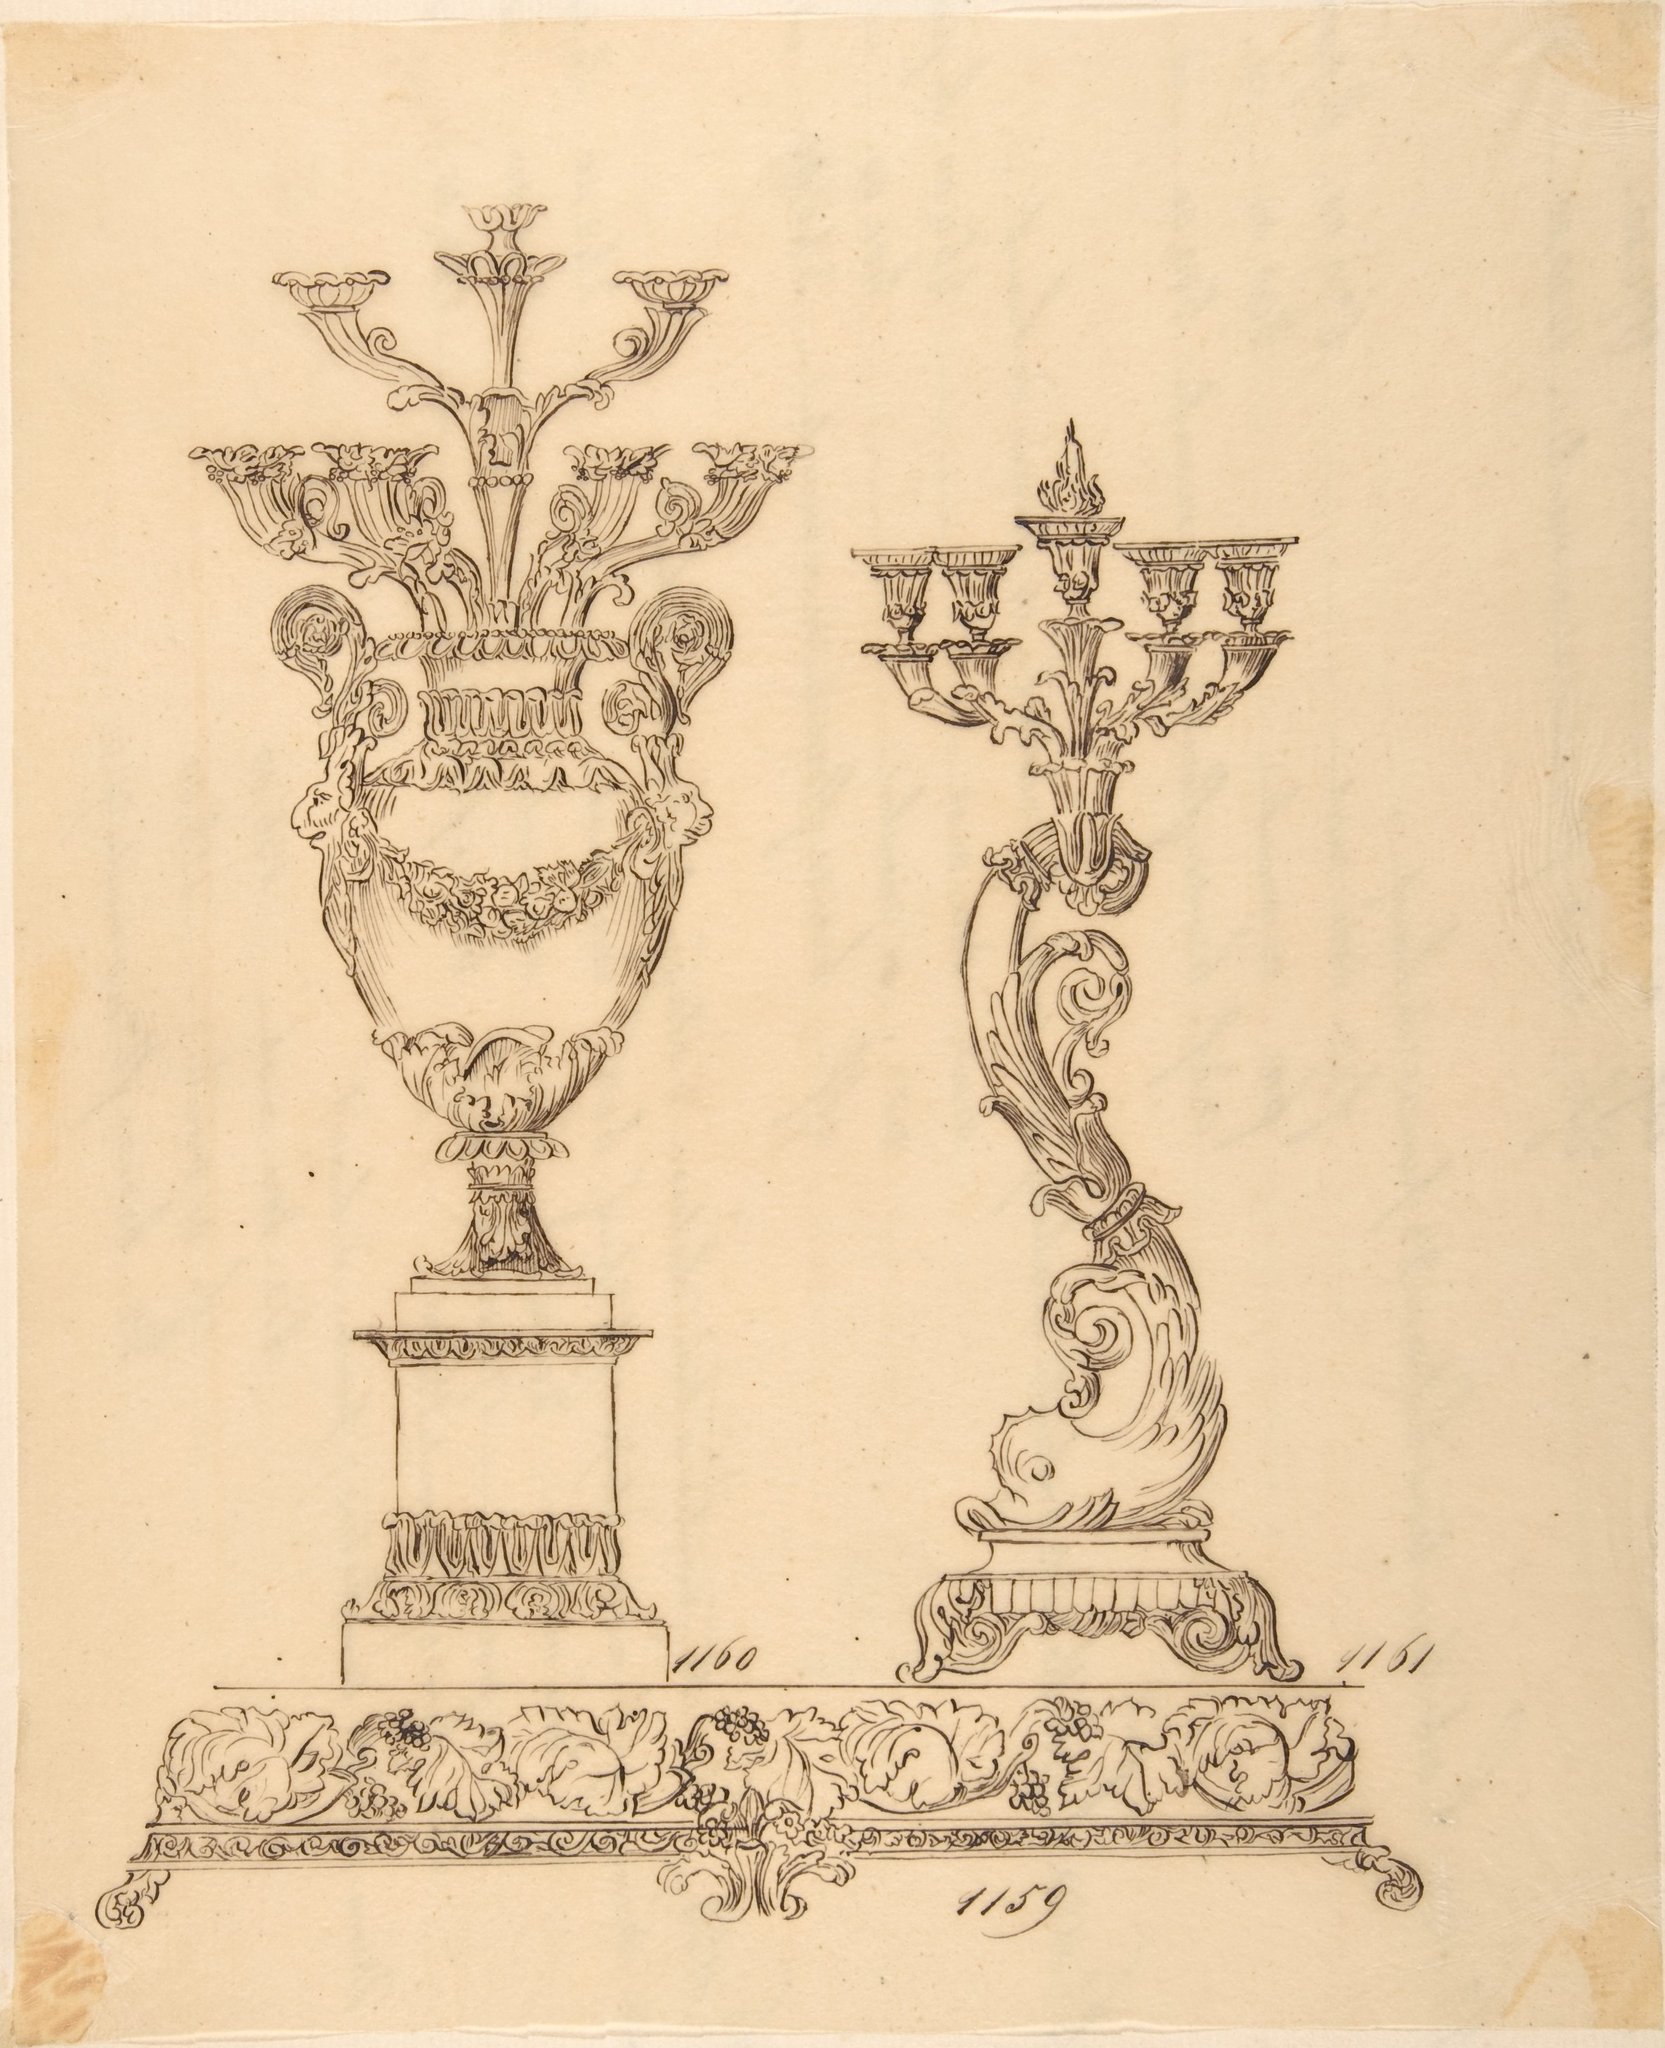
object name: drawing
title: Designs for Two Candelabras and a Pedestal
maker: anonymous, french, 19th century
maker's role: artist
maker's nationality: french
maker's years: 1800-1900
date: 1801-1900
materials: ink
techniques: pen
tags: candelabra